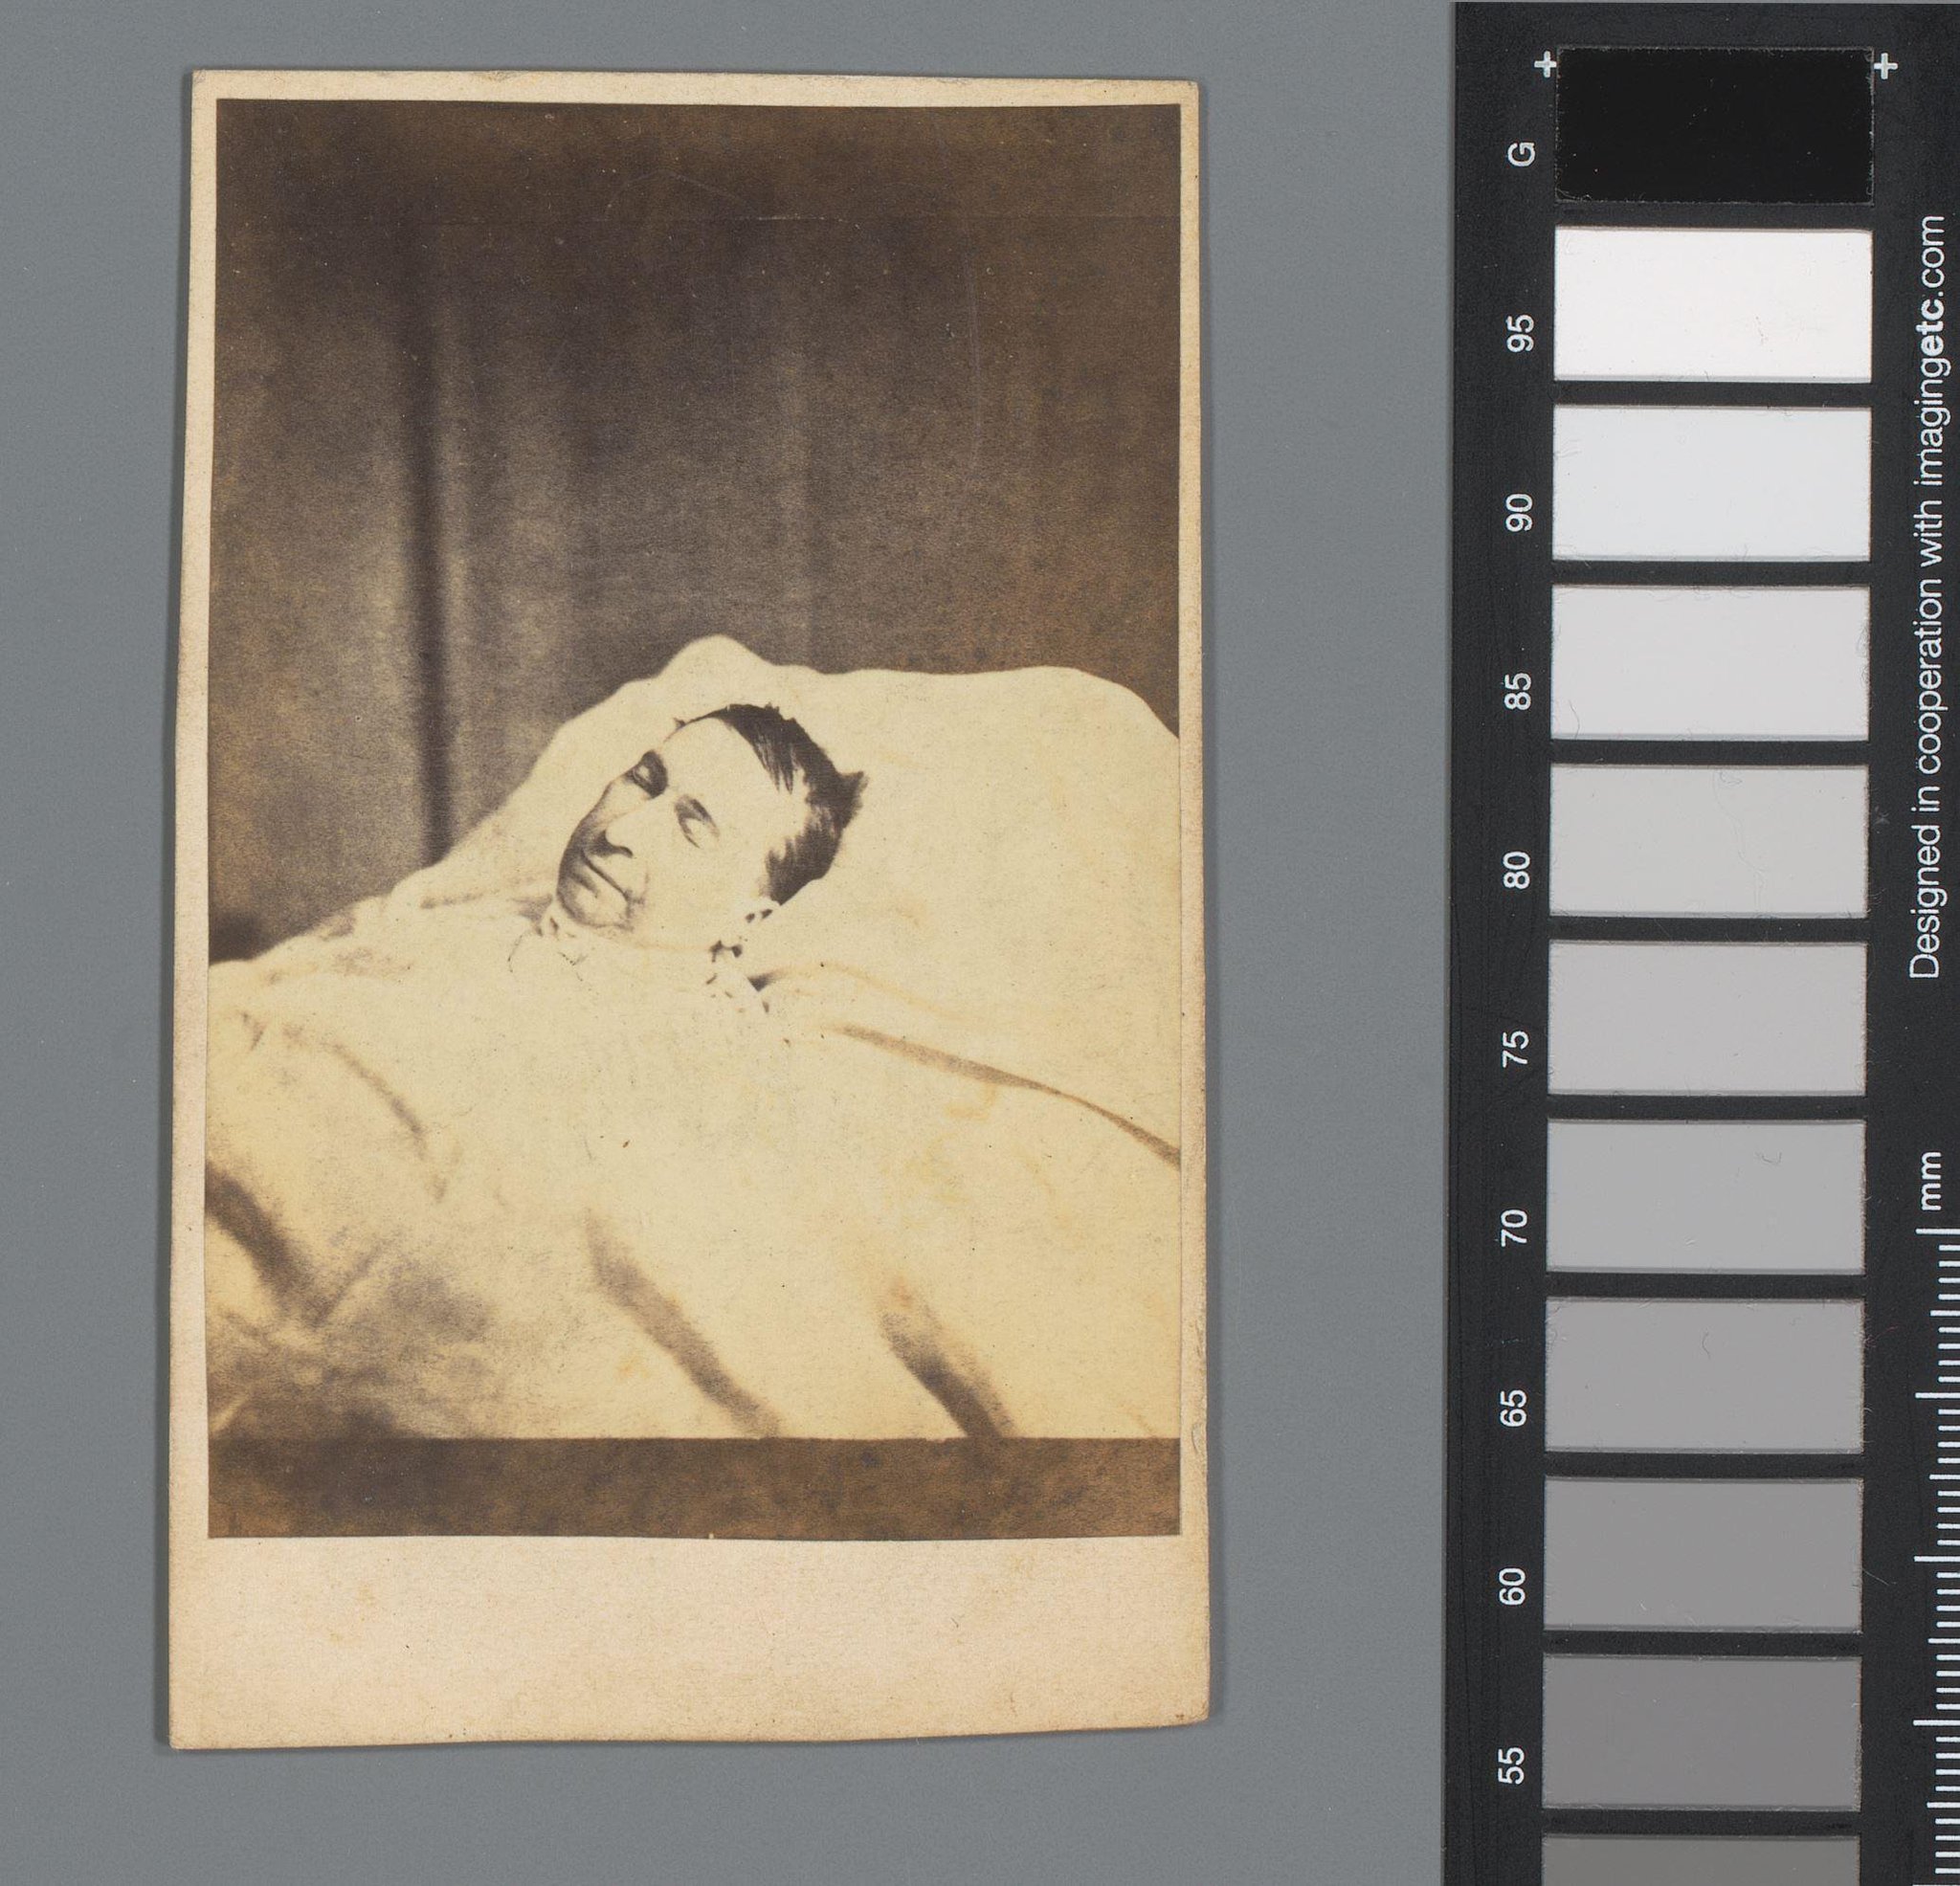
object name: photograph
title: Post-mortemportret van een onbekende man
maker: pierre vanhuysen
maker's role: fotograaf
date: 1863-1884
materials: cardboard, paper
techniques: albumen print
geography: leuven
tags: adult man, louvain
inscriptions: address: ‘rue de Paris, 22, à Louvain.’